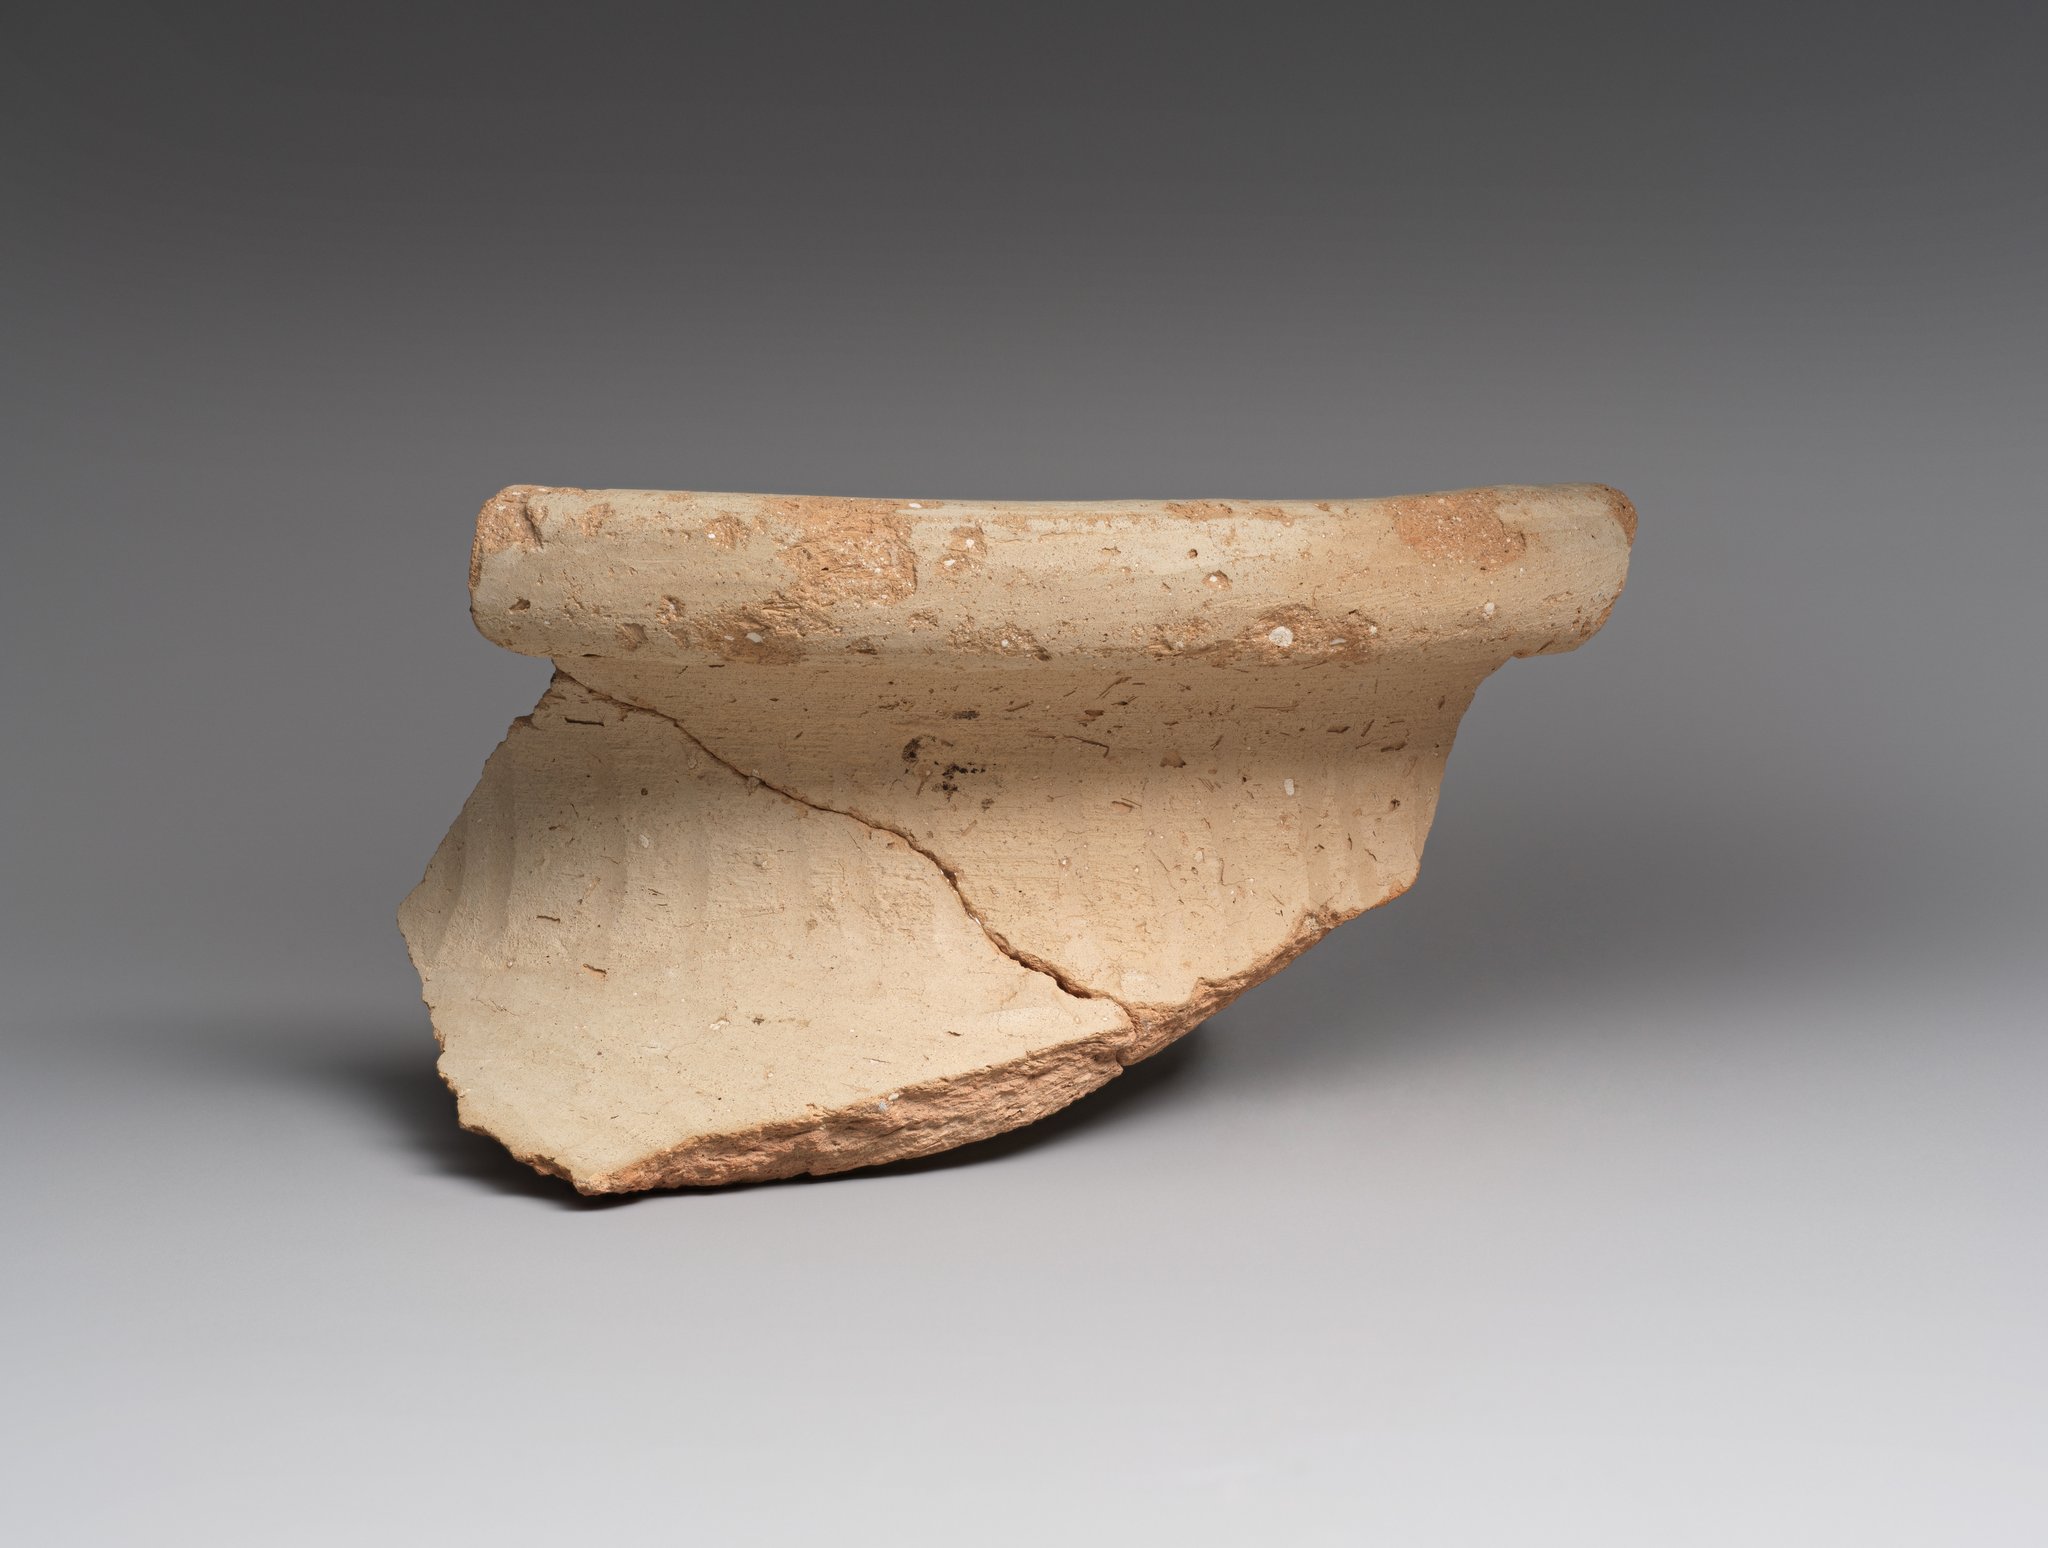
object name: jar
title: Jar rim sherd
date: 2333-2001 BCE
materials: ceramic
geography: mesopotamia